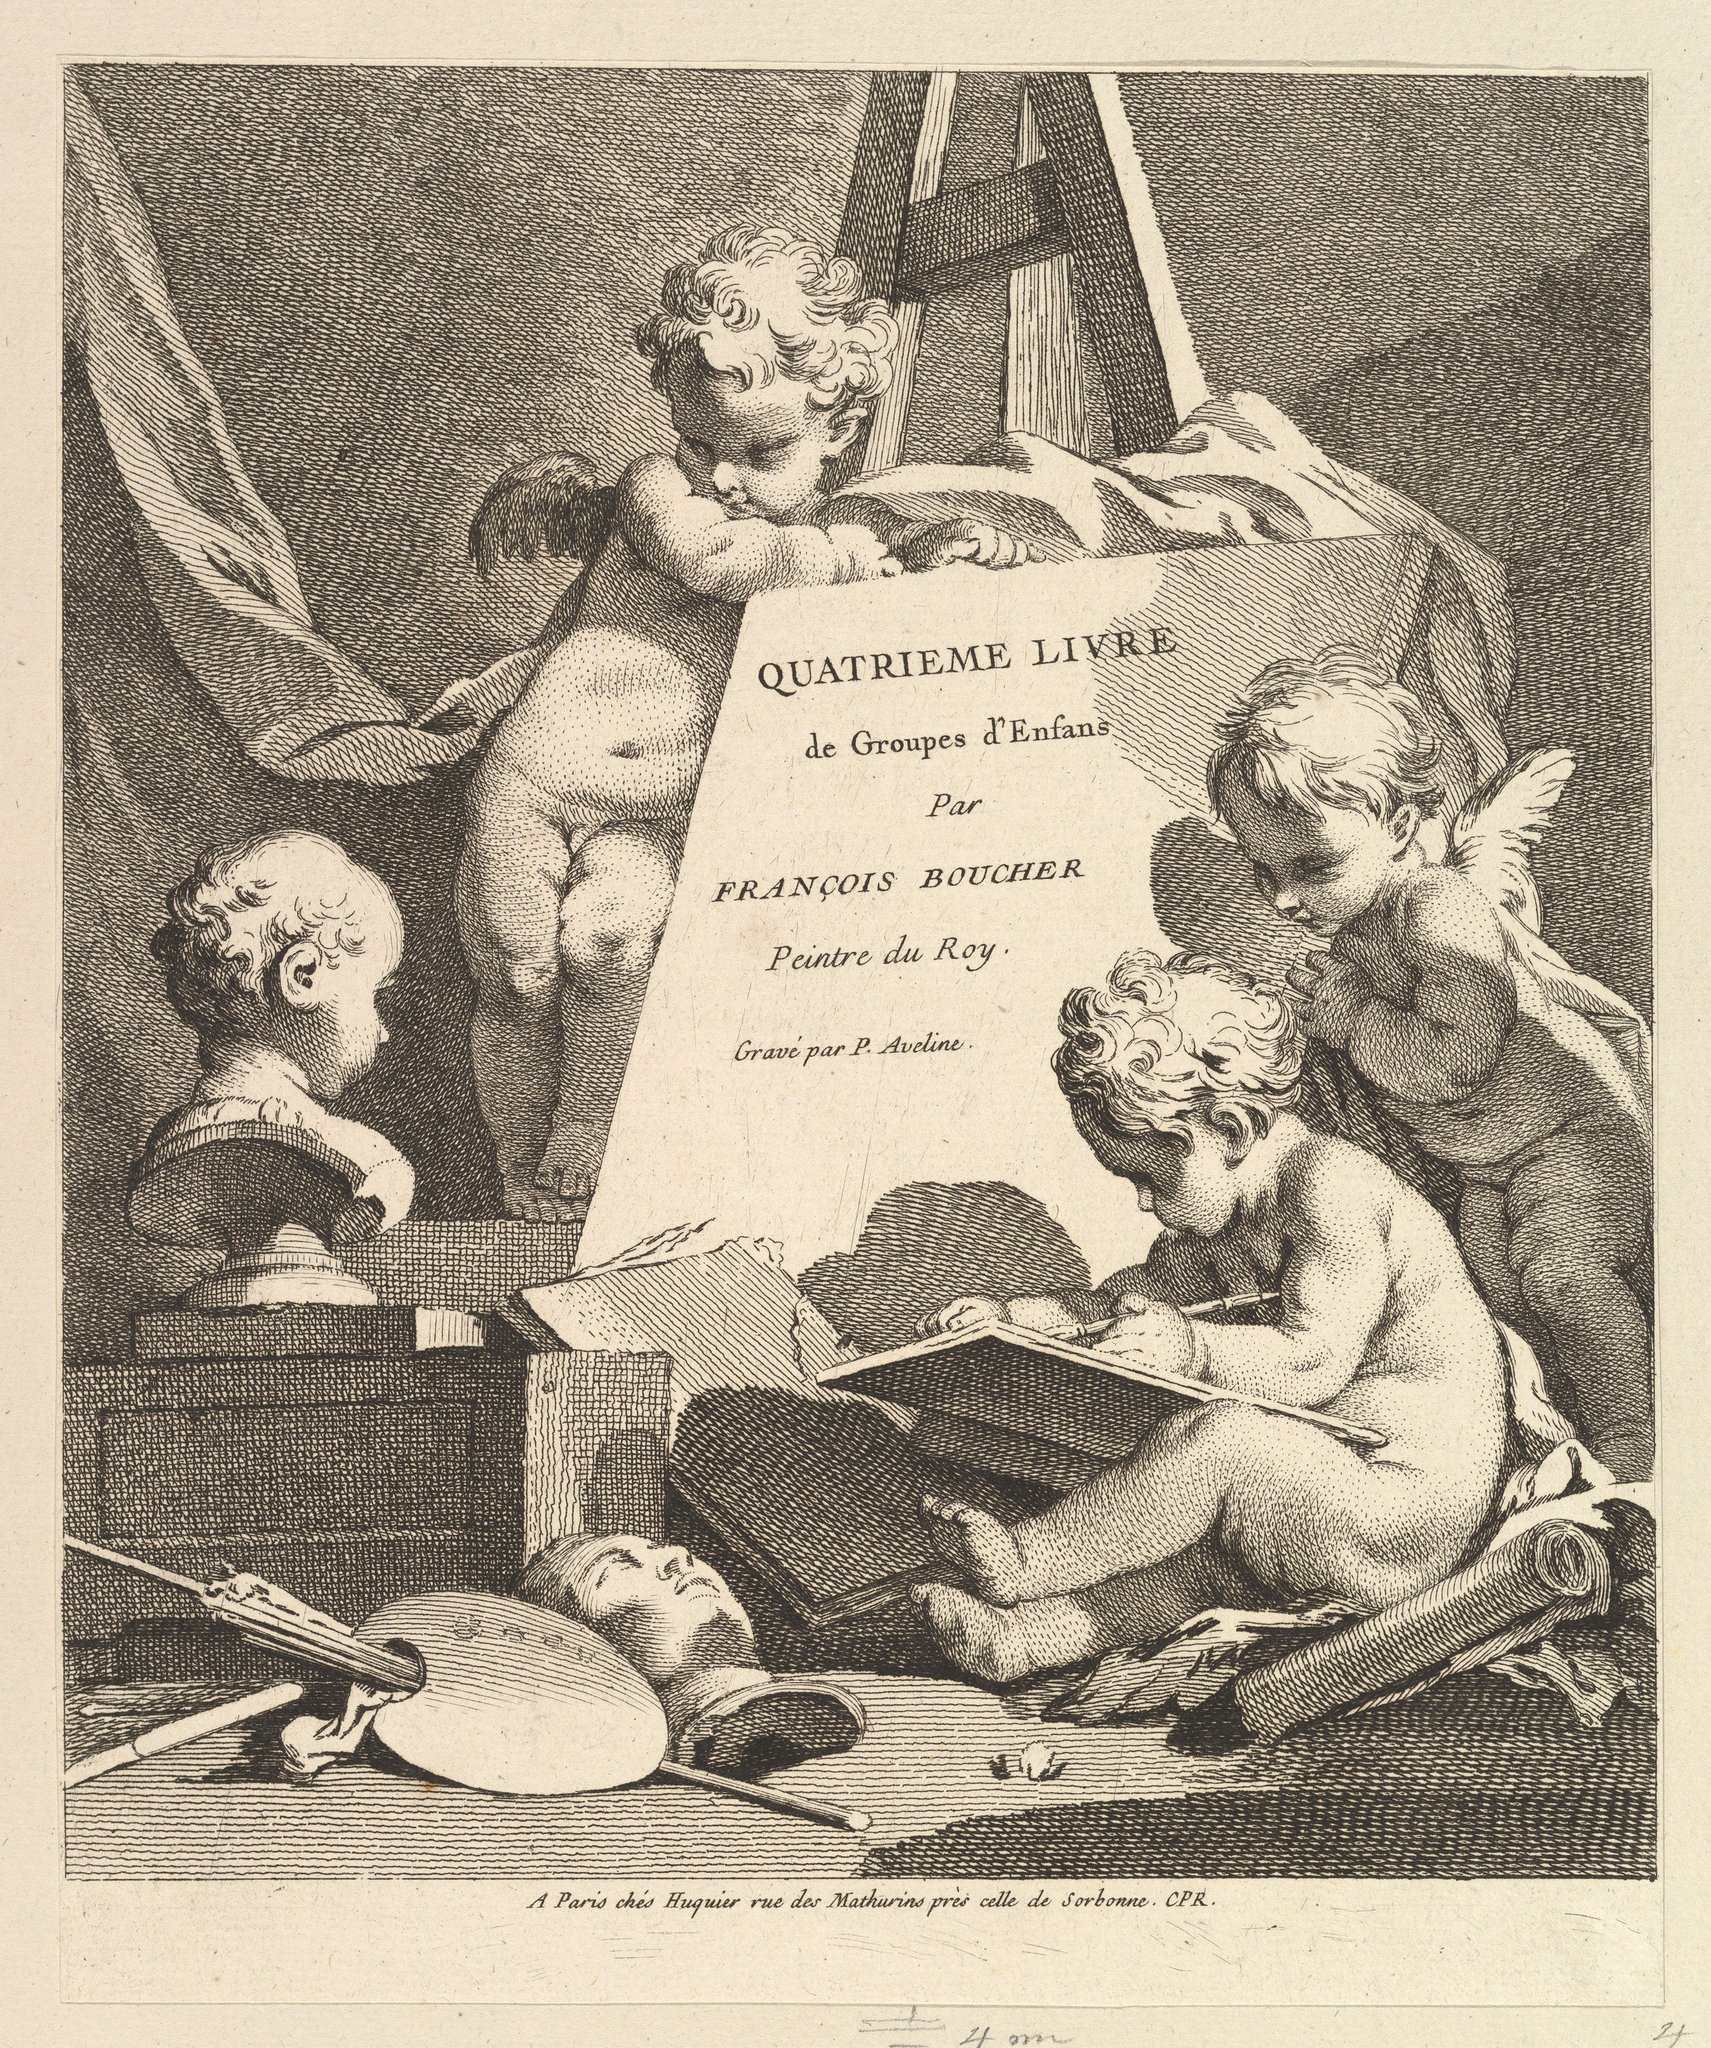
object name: collection ornament architecture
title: Frontispiece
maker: pierre alexandre aveline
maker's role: artist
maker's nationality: french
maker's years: 1702-1760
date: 1727-1760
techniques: engraving, etching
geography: france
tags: putti,writing